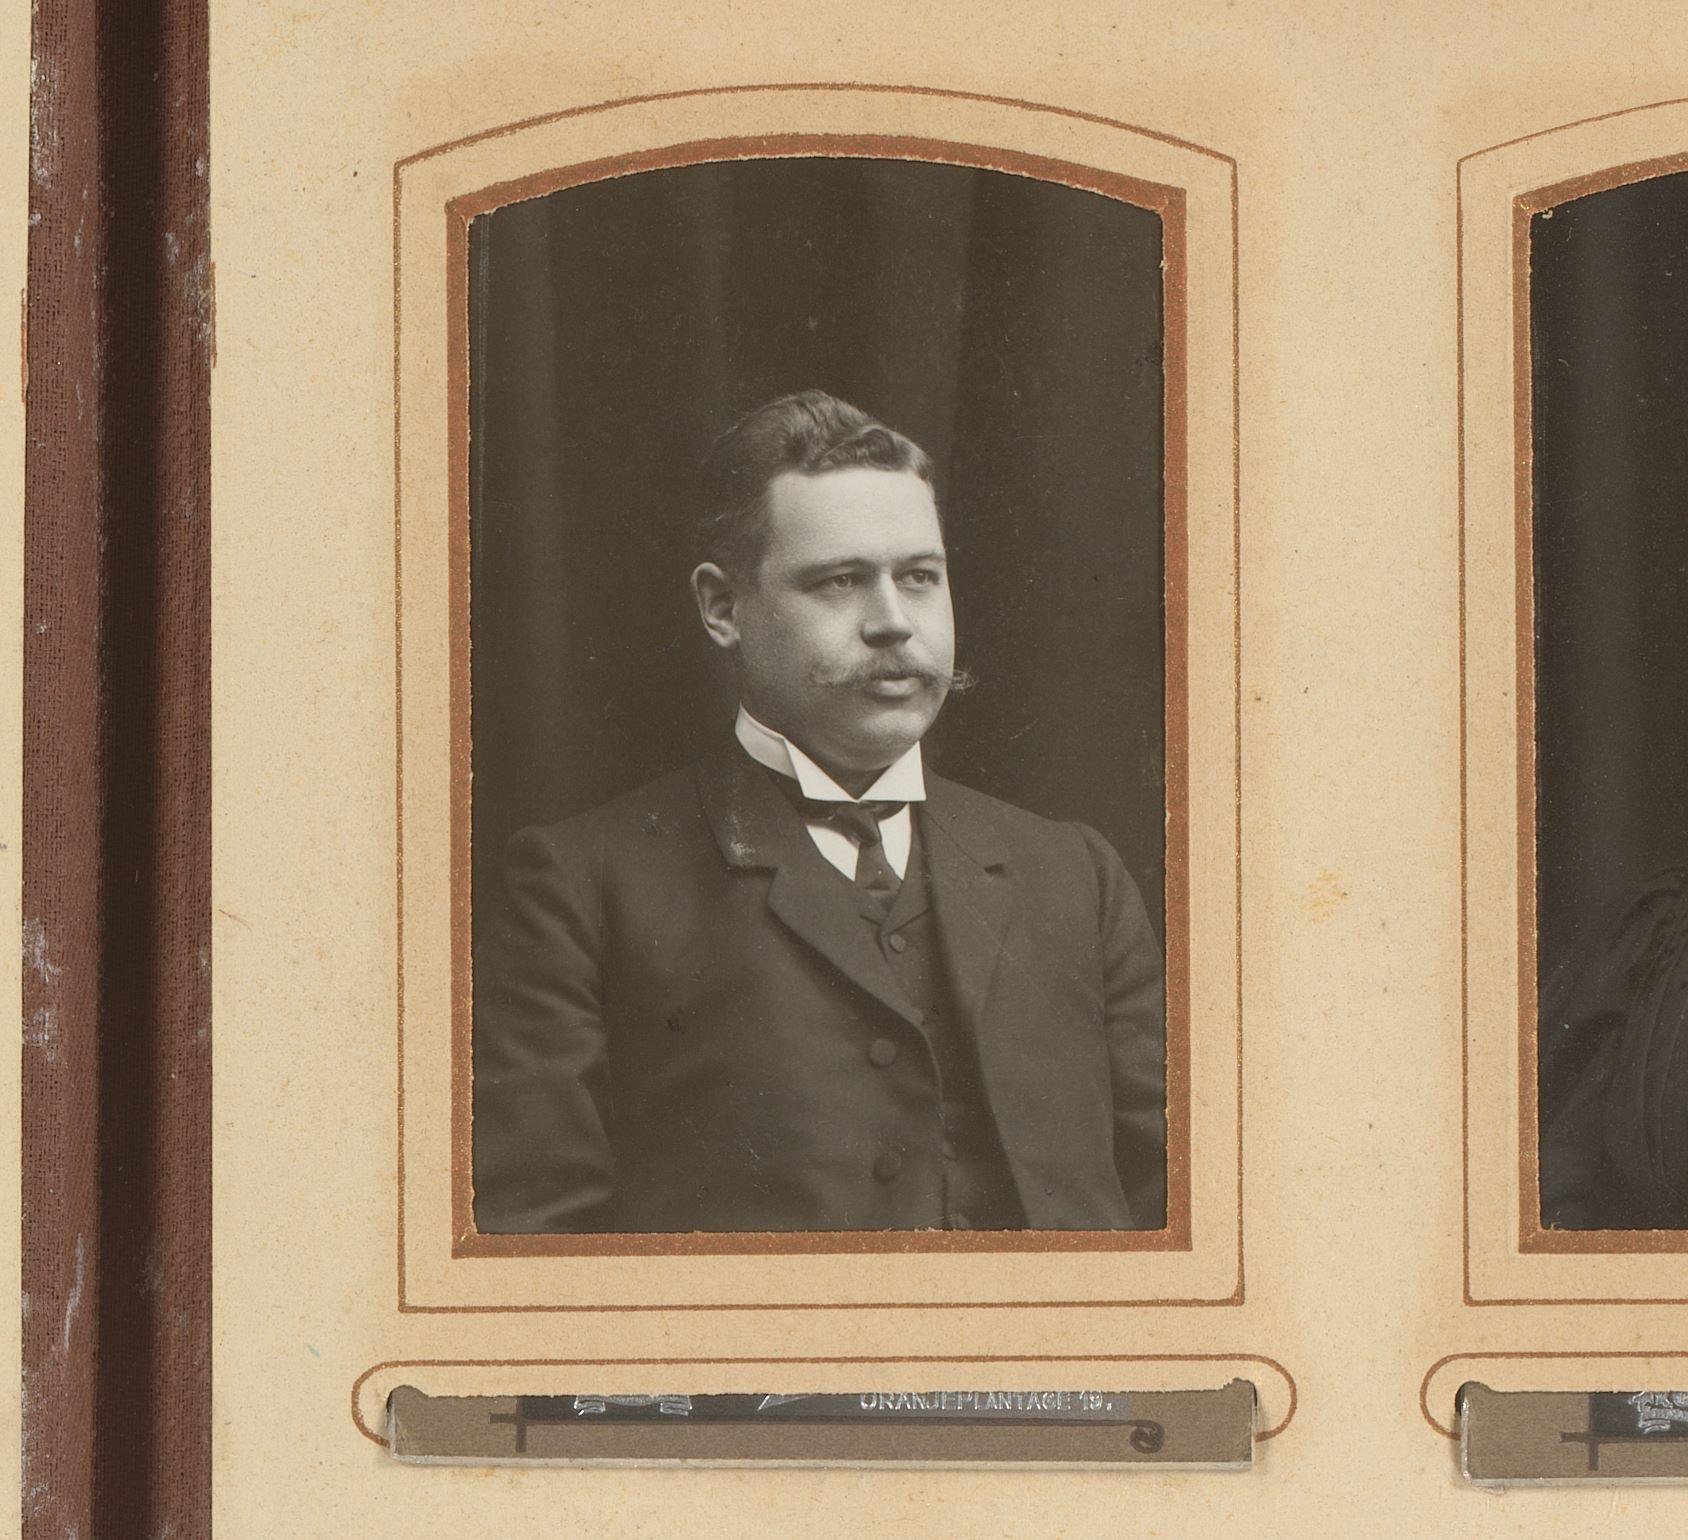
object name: album leaf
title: Portret van een man met snor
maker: johannes van doorne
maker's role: fotograaf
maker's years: 1869-1926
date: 1899-1920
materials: cardboard, photographic support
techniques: collodion silver print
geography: the hague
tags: moustache, historical persons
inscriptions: inscription: ‘Joh. van Doorne/ Delft/ Oranjeplantage 19’